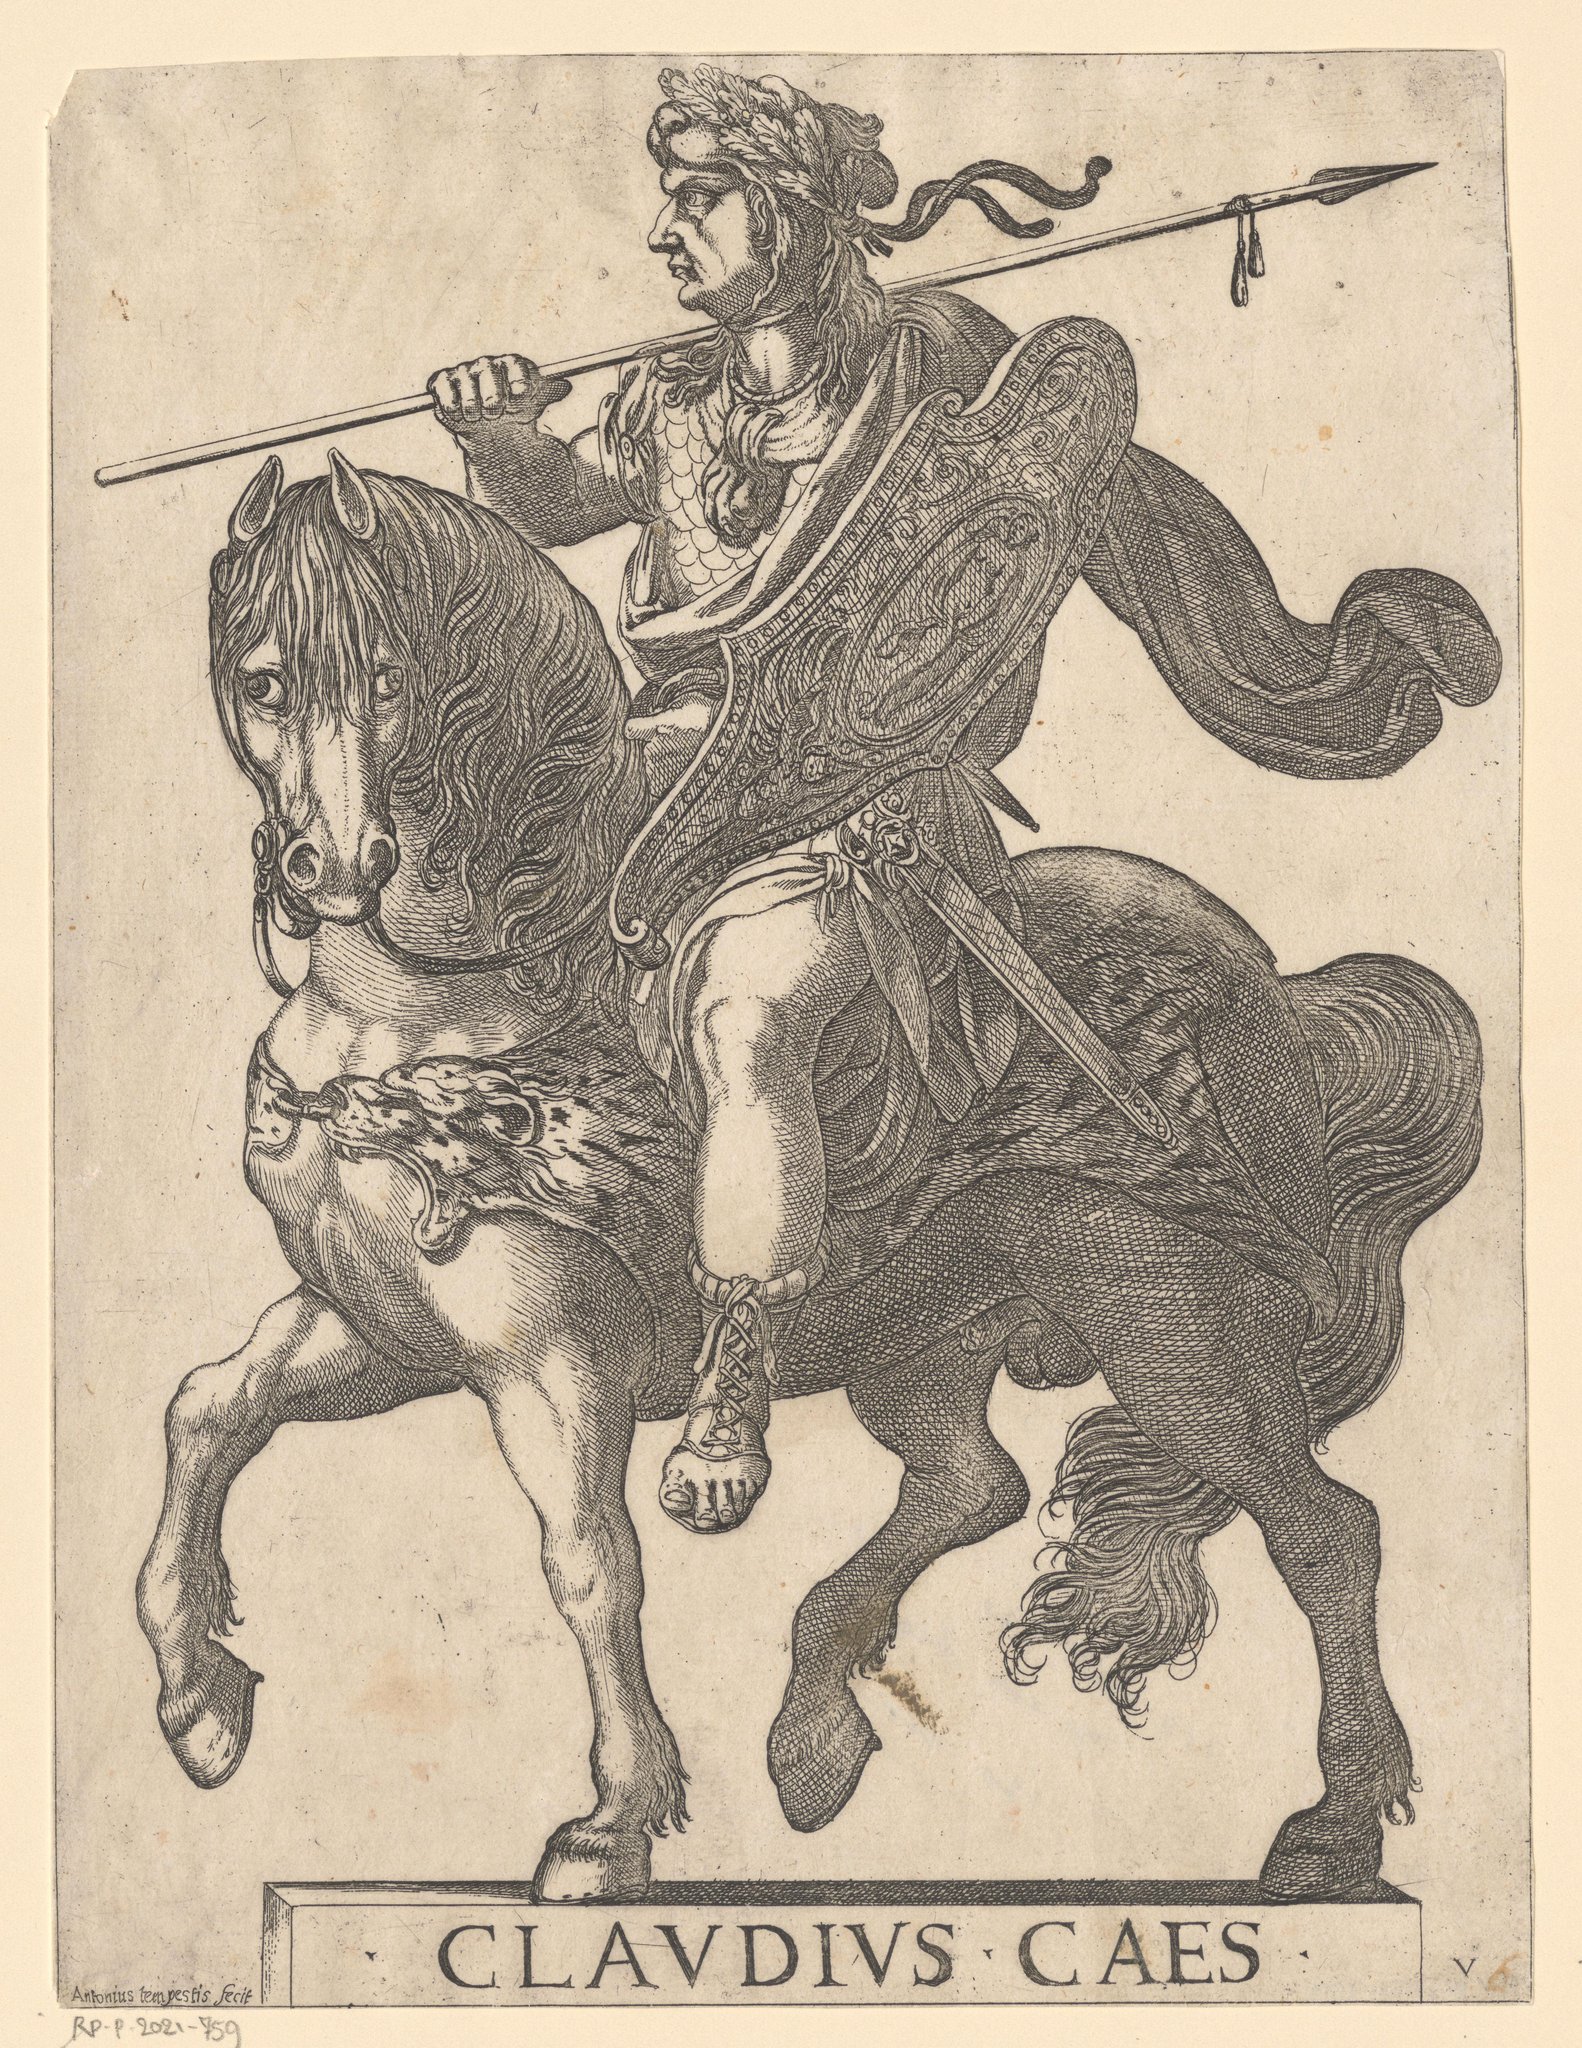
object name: print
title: Eerste twaalf Romeinse keizers te paard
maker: antonio tempesta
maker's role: draughtsman, painter, print maker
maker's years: 1555-1630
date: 1596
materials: paper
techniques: etching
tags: historical persons, horse, (story of) claudius the roman emperor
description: Onderdeel van een prentenreeks van twaalf prenten van Romeinse keizers.